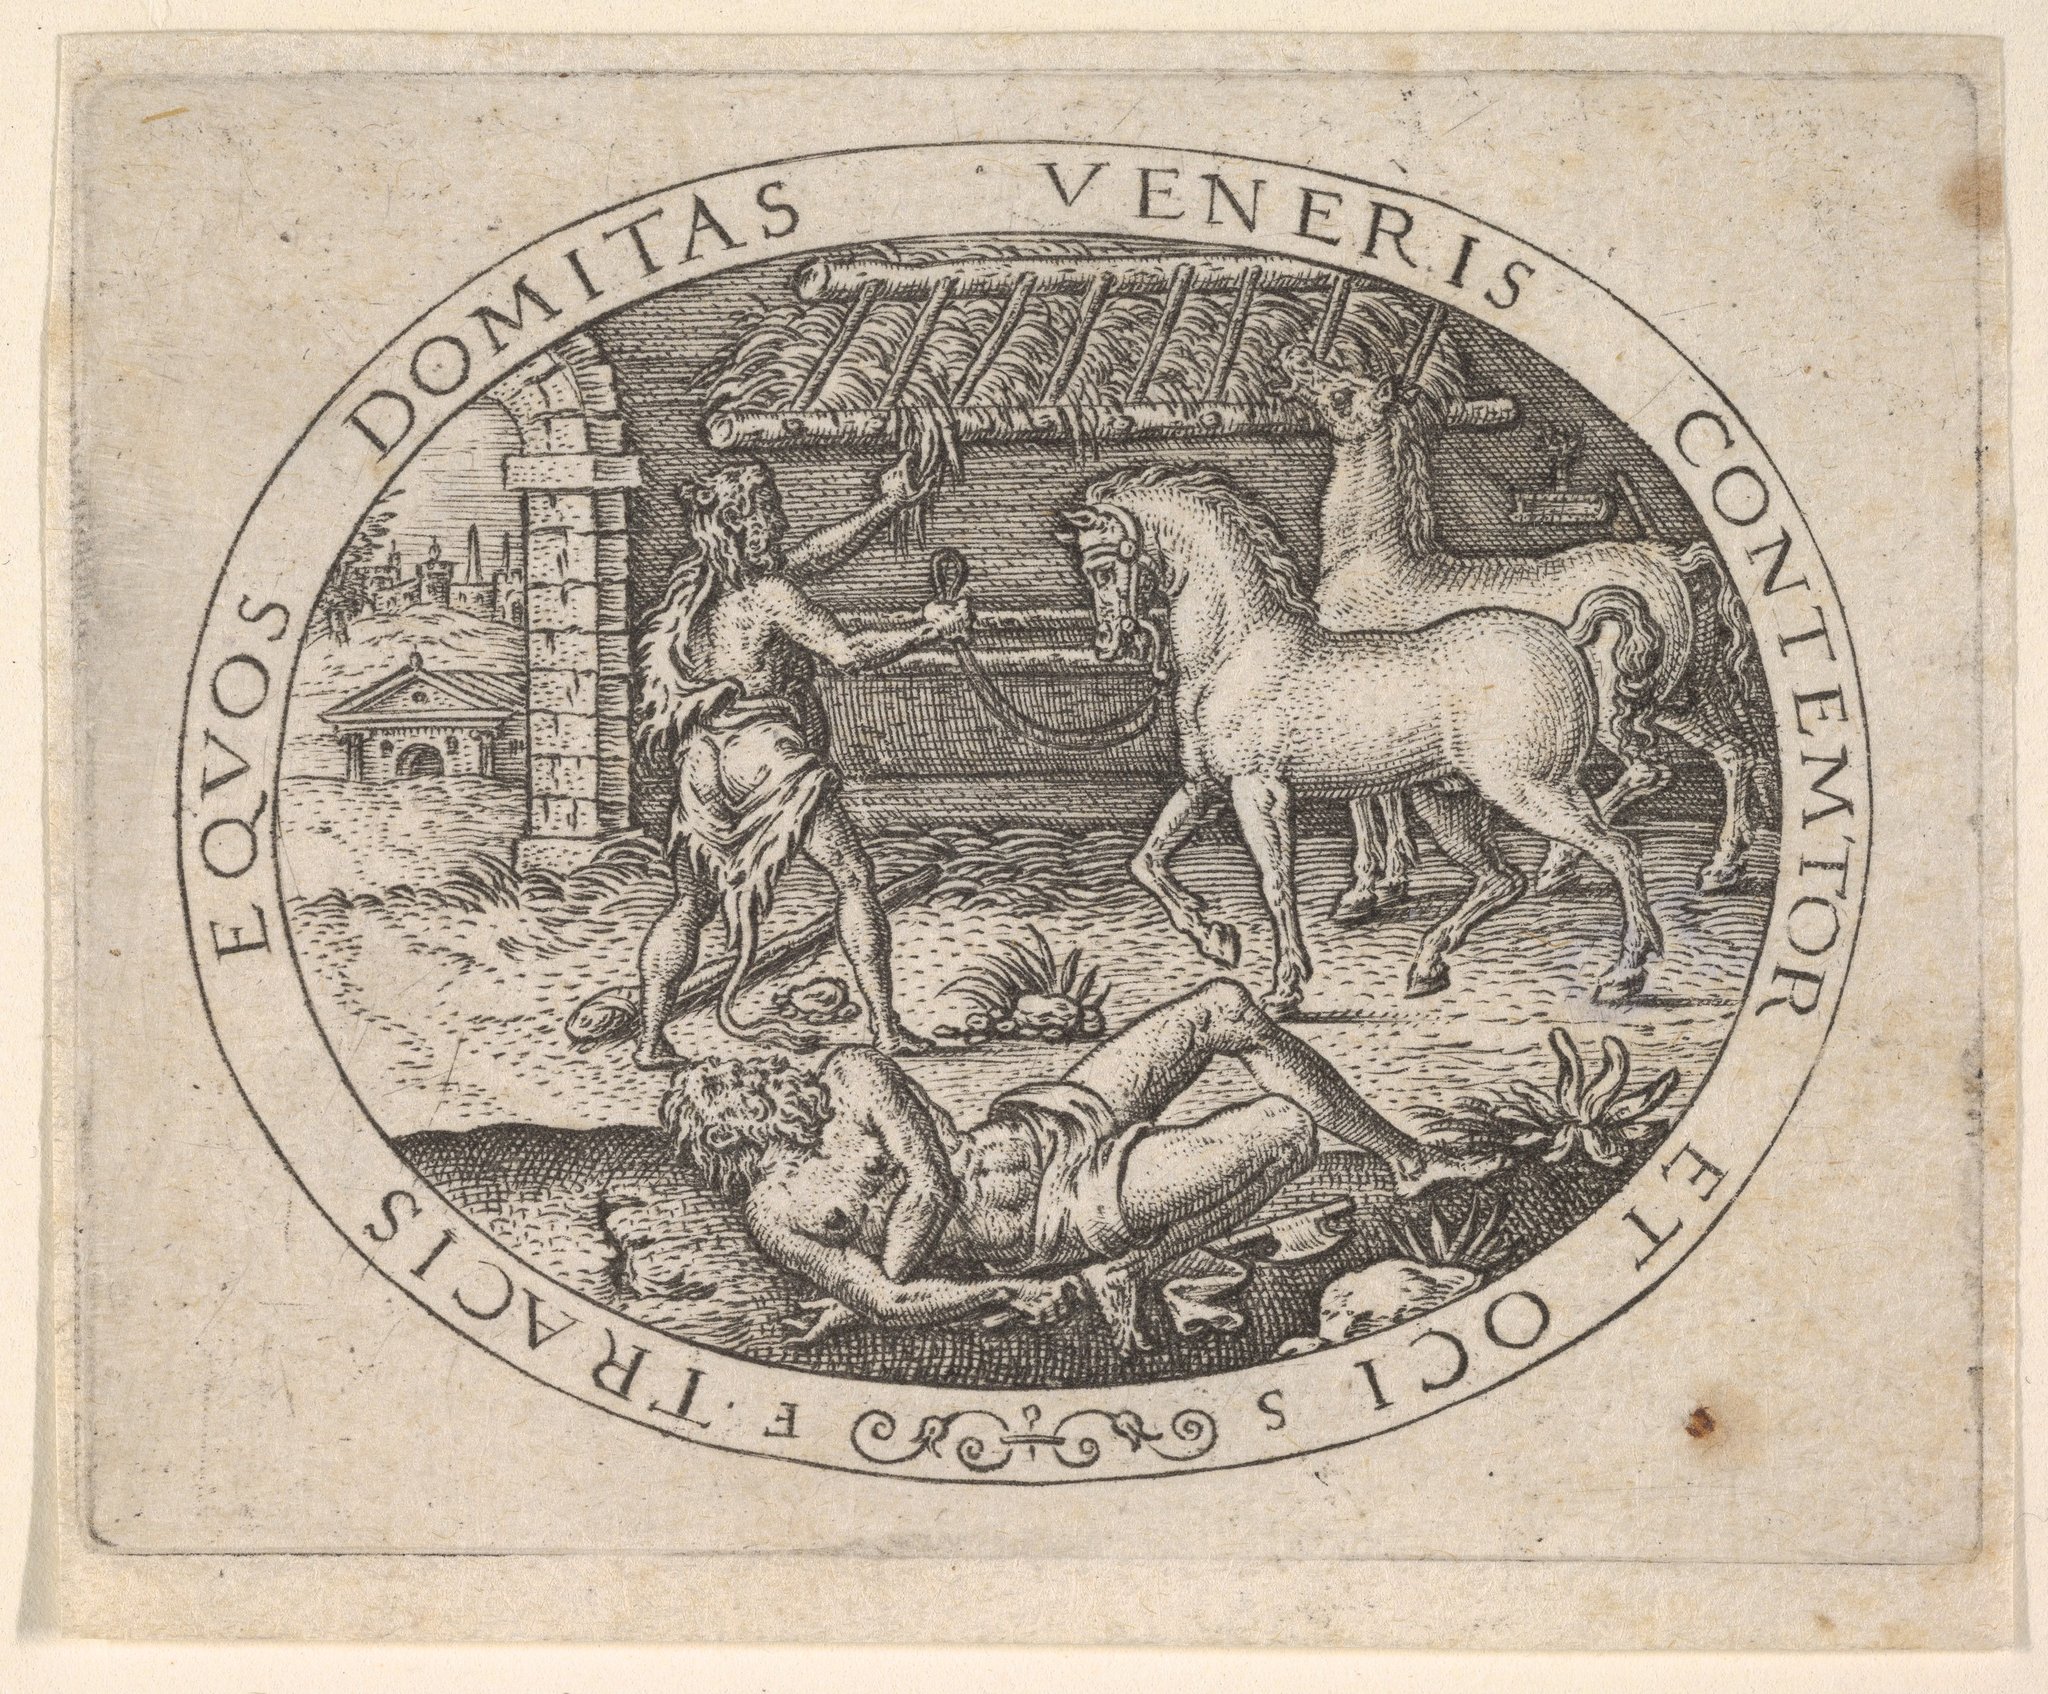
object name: print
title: Hercules Stealing the Horses of Diomedes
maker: etienne delaune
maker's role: artist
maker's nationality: french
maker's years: 1518-1583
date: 1540-1583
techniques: engraving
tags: men,hercules,horses